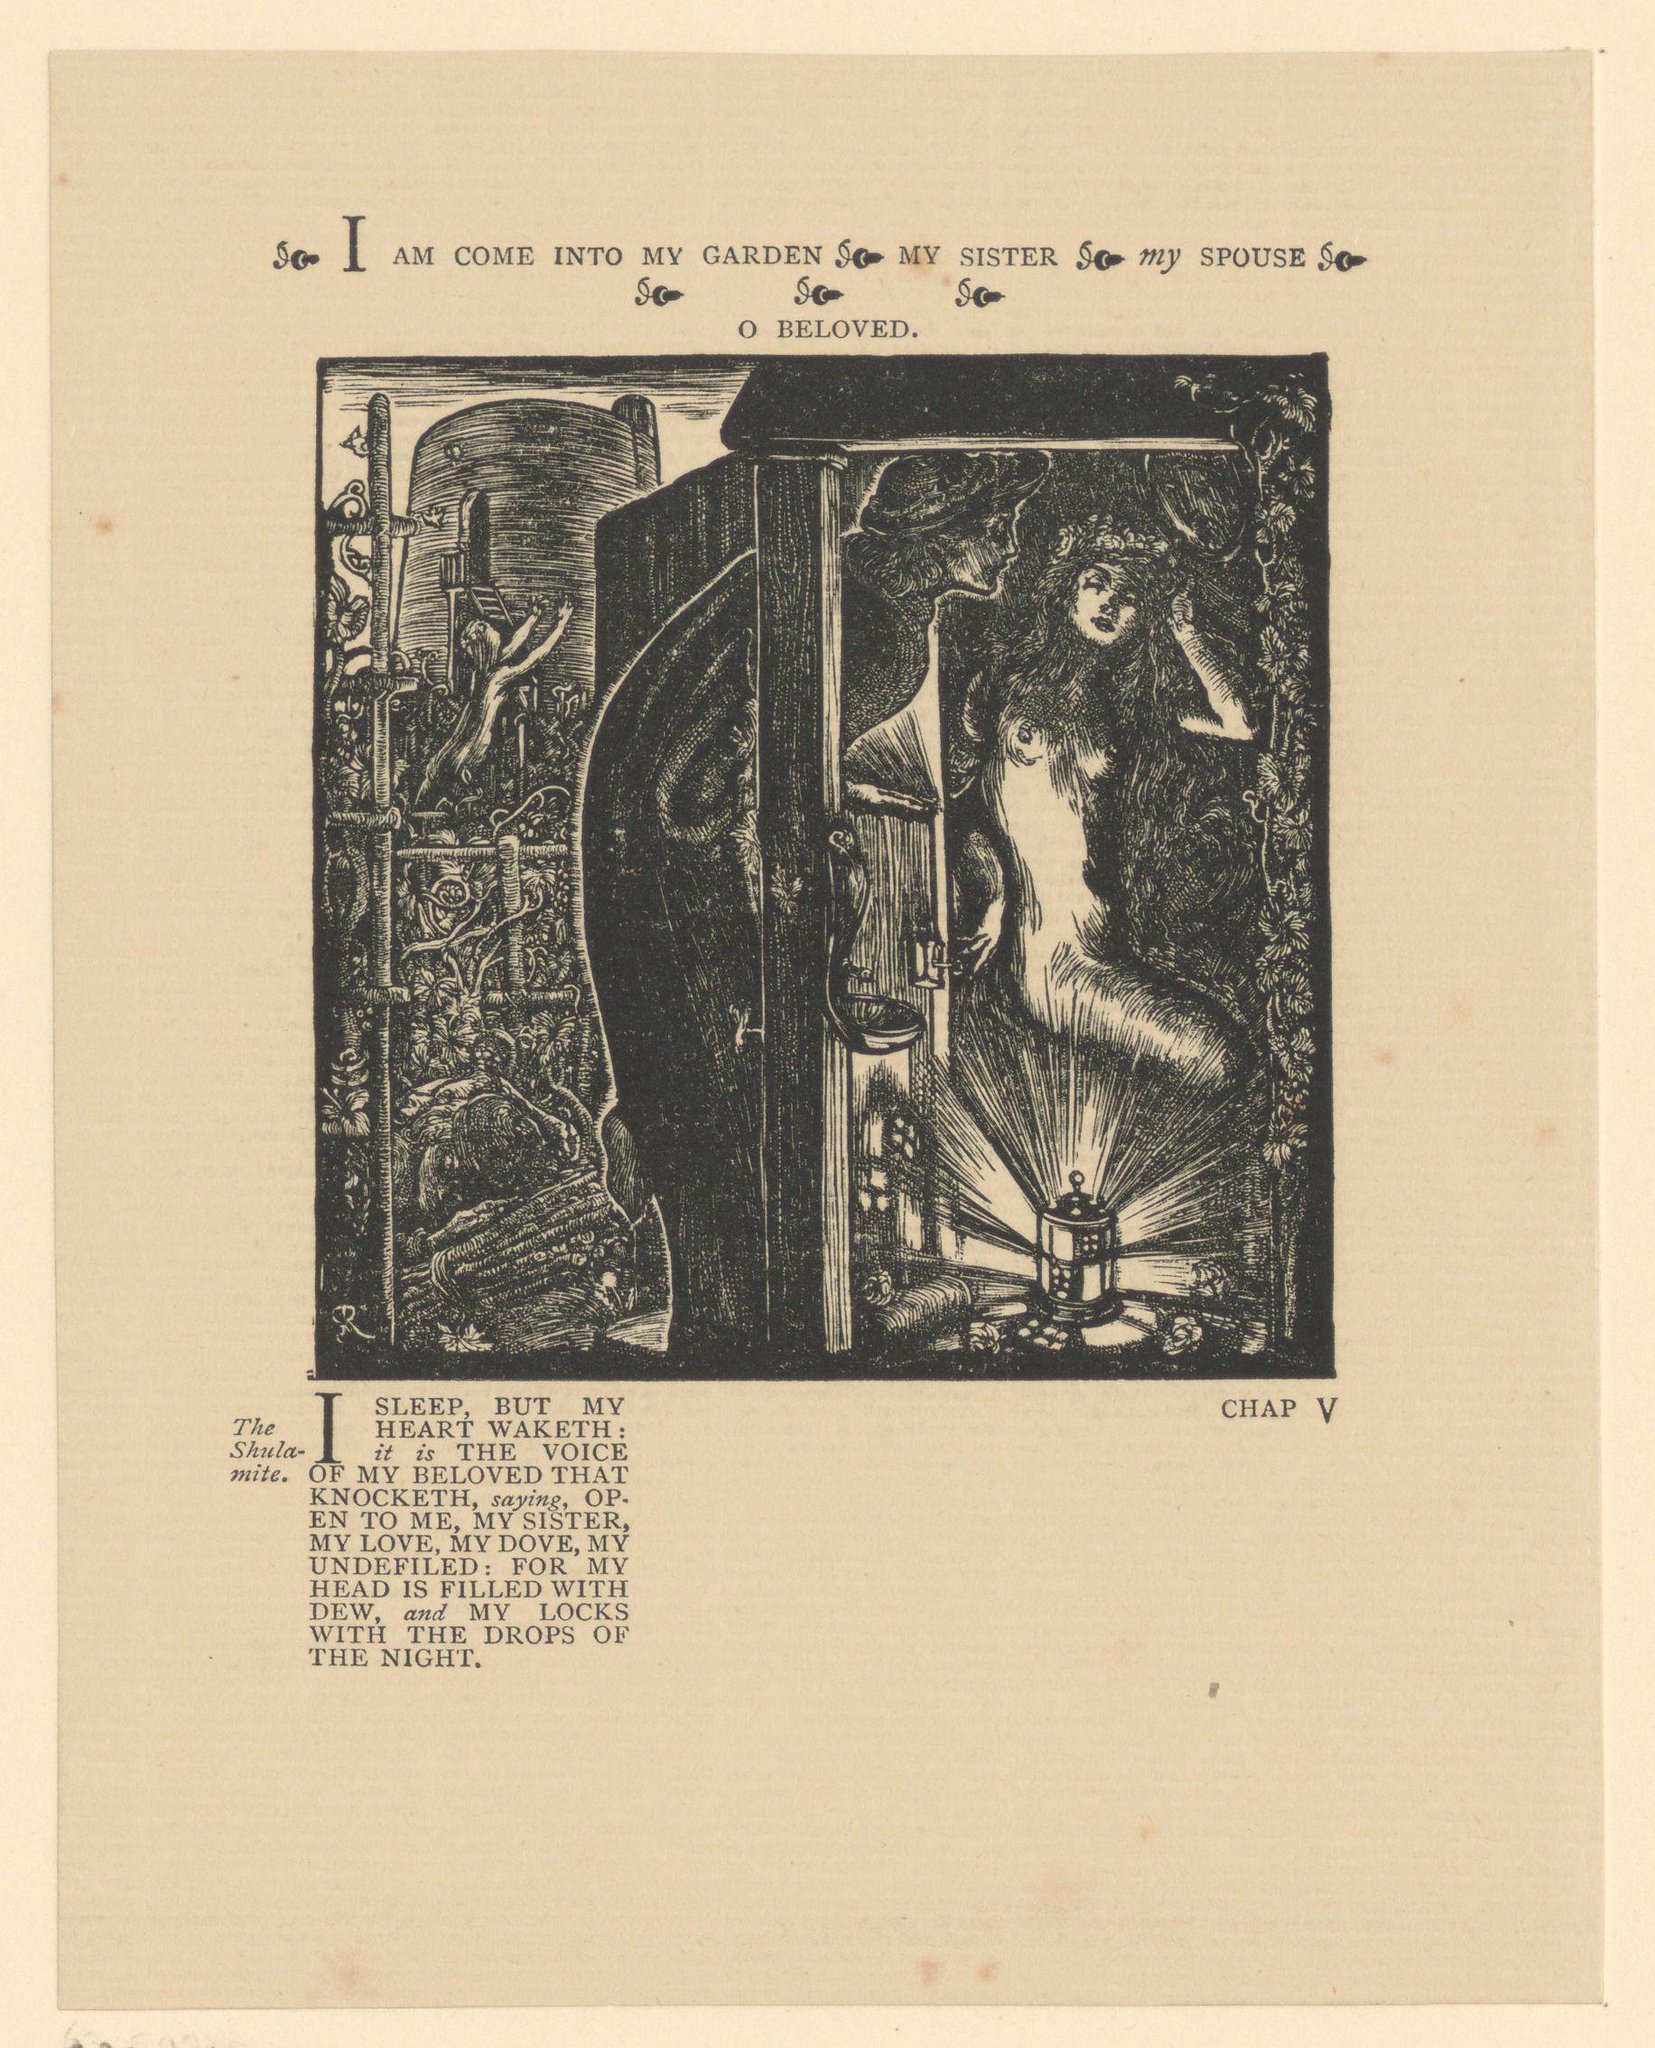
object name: print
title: Sulamith krijgt bezoek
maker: charles ricketts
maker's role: print maker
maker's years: 1866-1931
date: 1892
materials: paper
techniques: letterpress printing, engraving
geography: london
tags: visiting; receiving guests; elegant company, lantern, the (nude) human figure; 'corpo humano' (ripa) - aa - female human figure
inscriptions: collector's mark: Lugt 2228